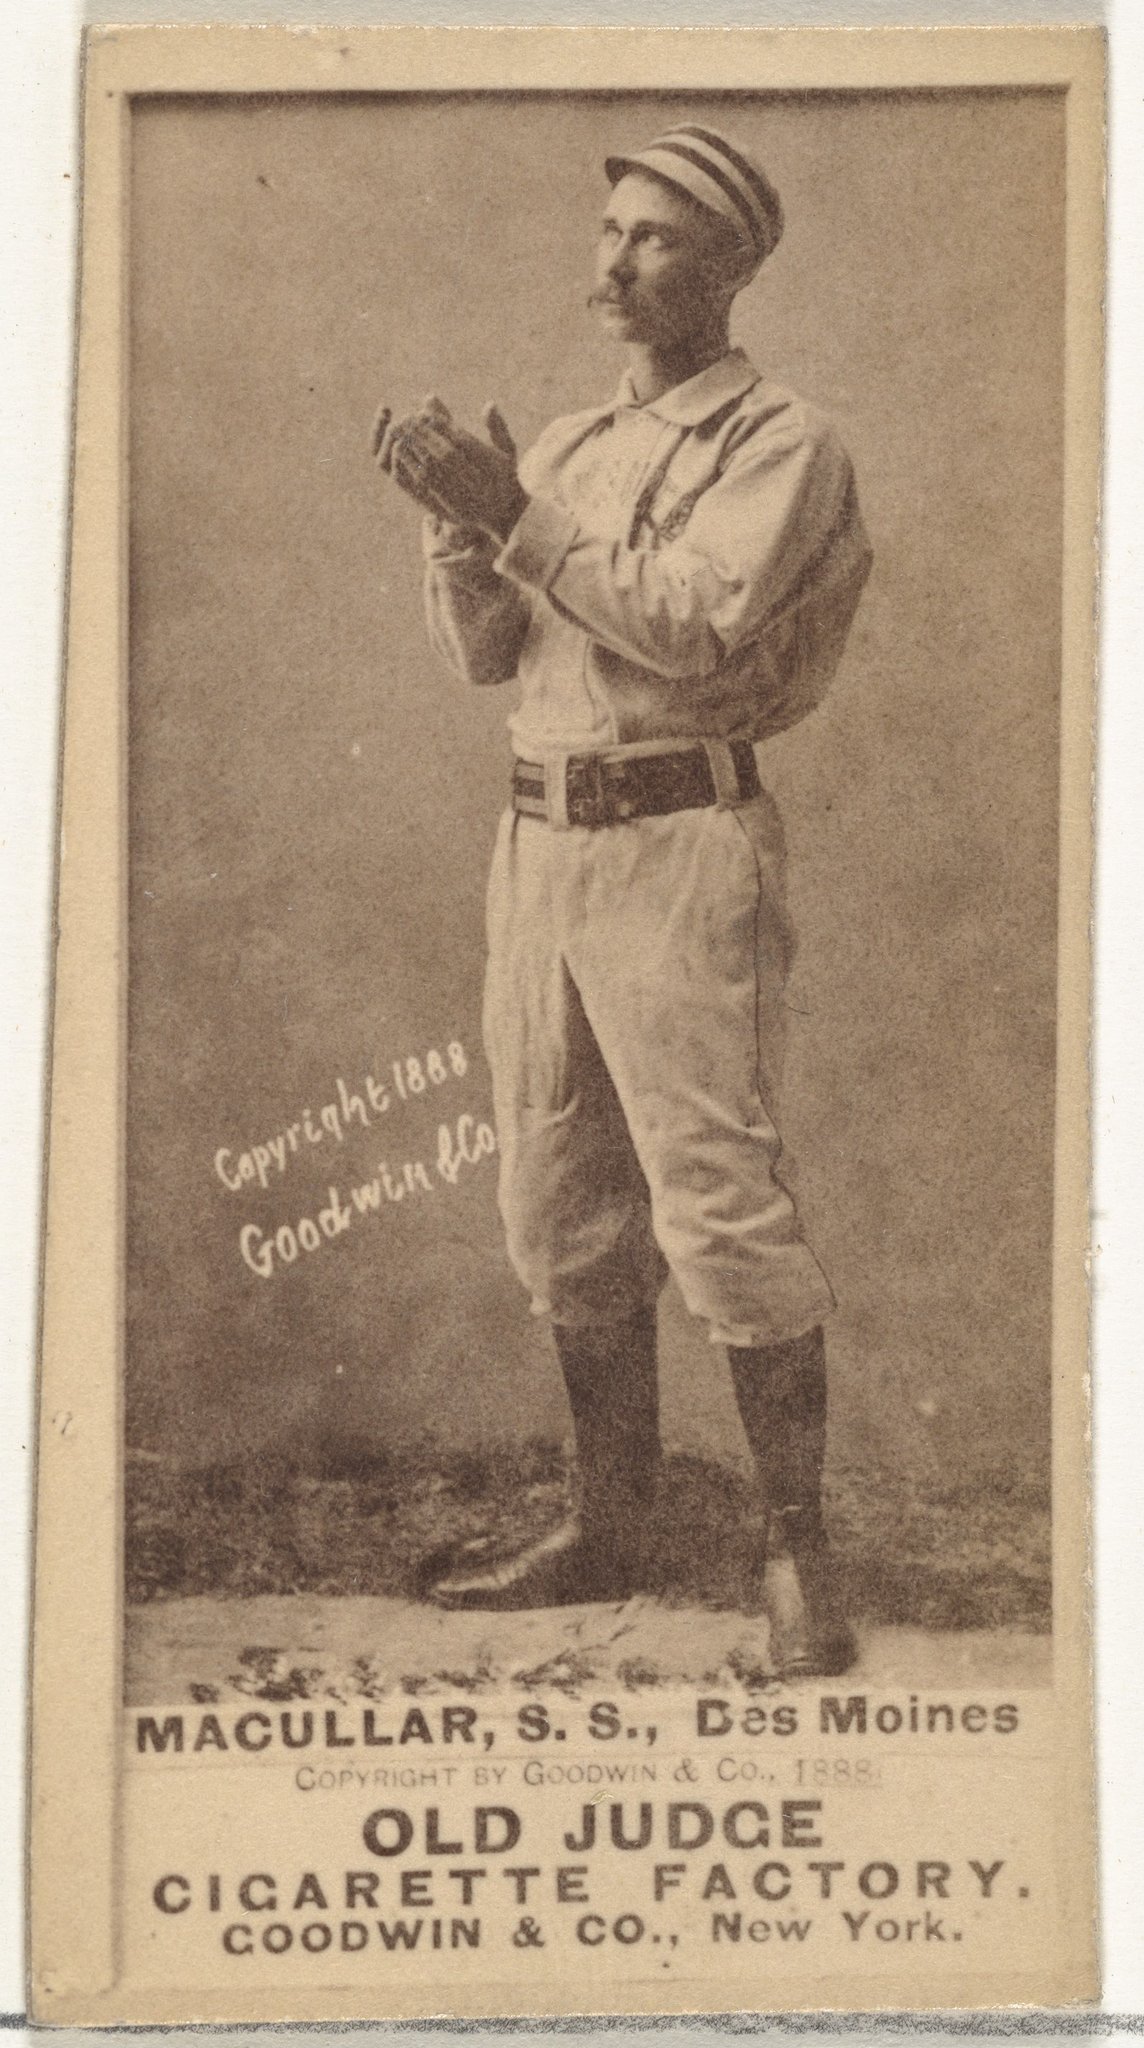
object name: baseball card, photograph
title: James F. "Jimmy" Macullar, Shortstop, Des Moines Prohibitionists, from the Old Judge series (N172) for Old Judge Cigarettes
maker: goodwin & company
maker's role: publisher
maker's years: 1850-1950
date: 1888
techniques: albumen silver print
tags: men,portraits,baseball,athletes